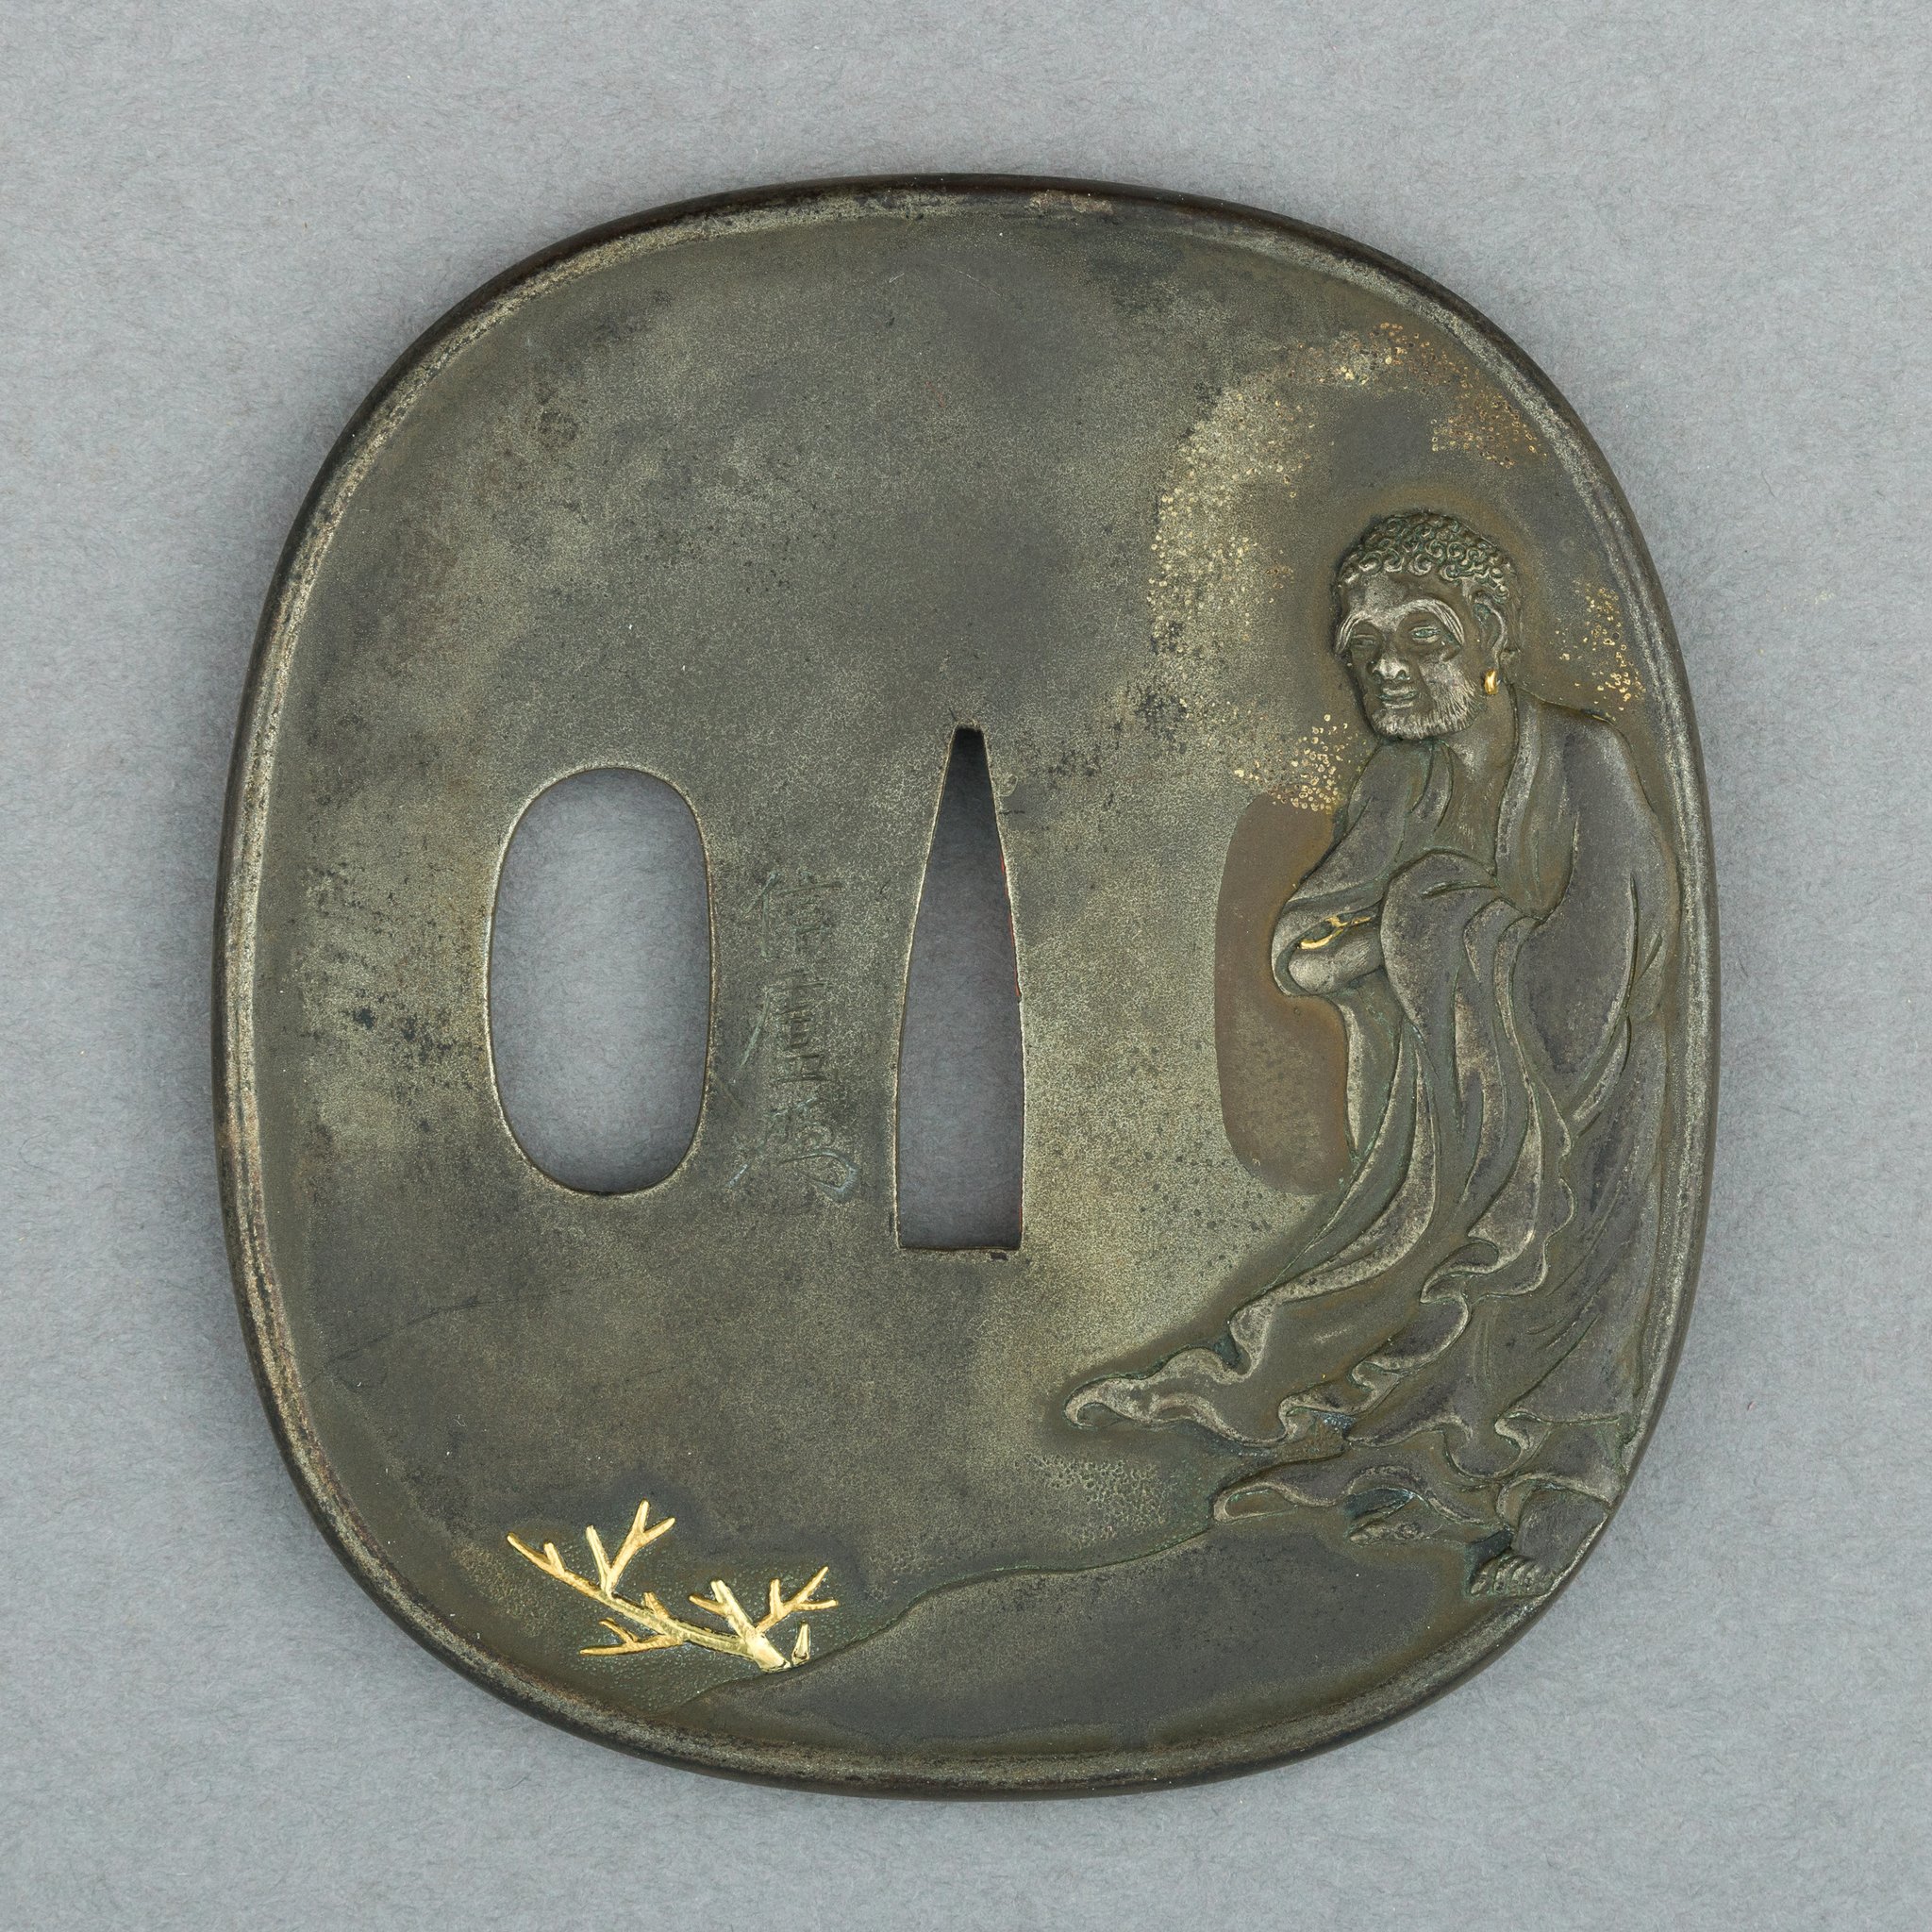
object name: sword guard tsuba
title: Sword Guard (Tsuba)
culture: japanese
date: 1615-1868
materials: silver alloy, gold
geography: japan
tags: buddha